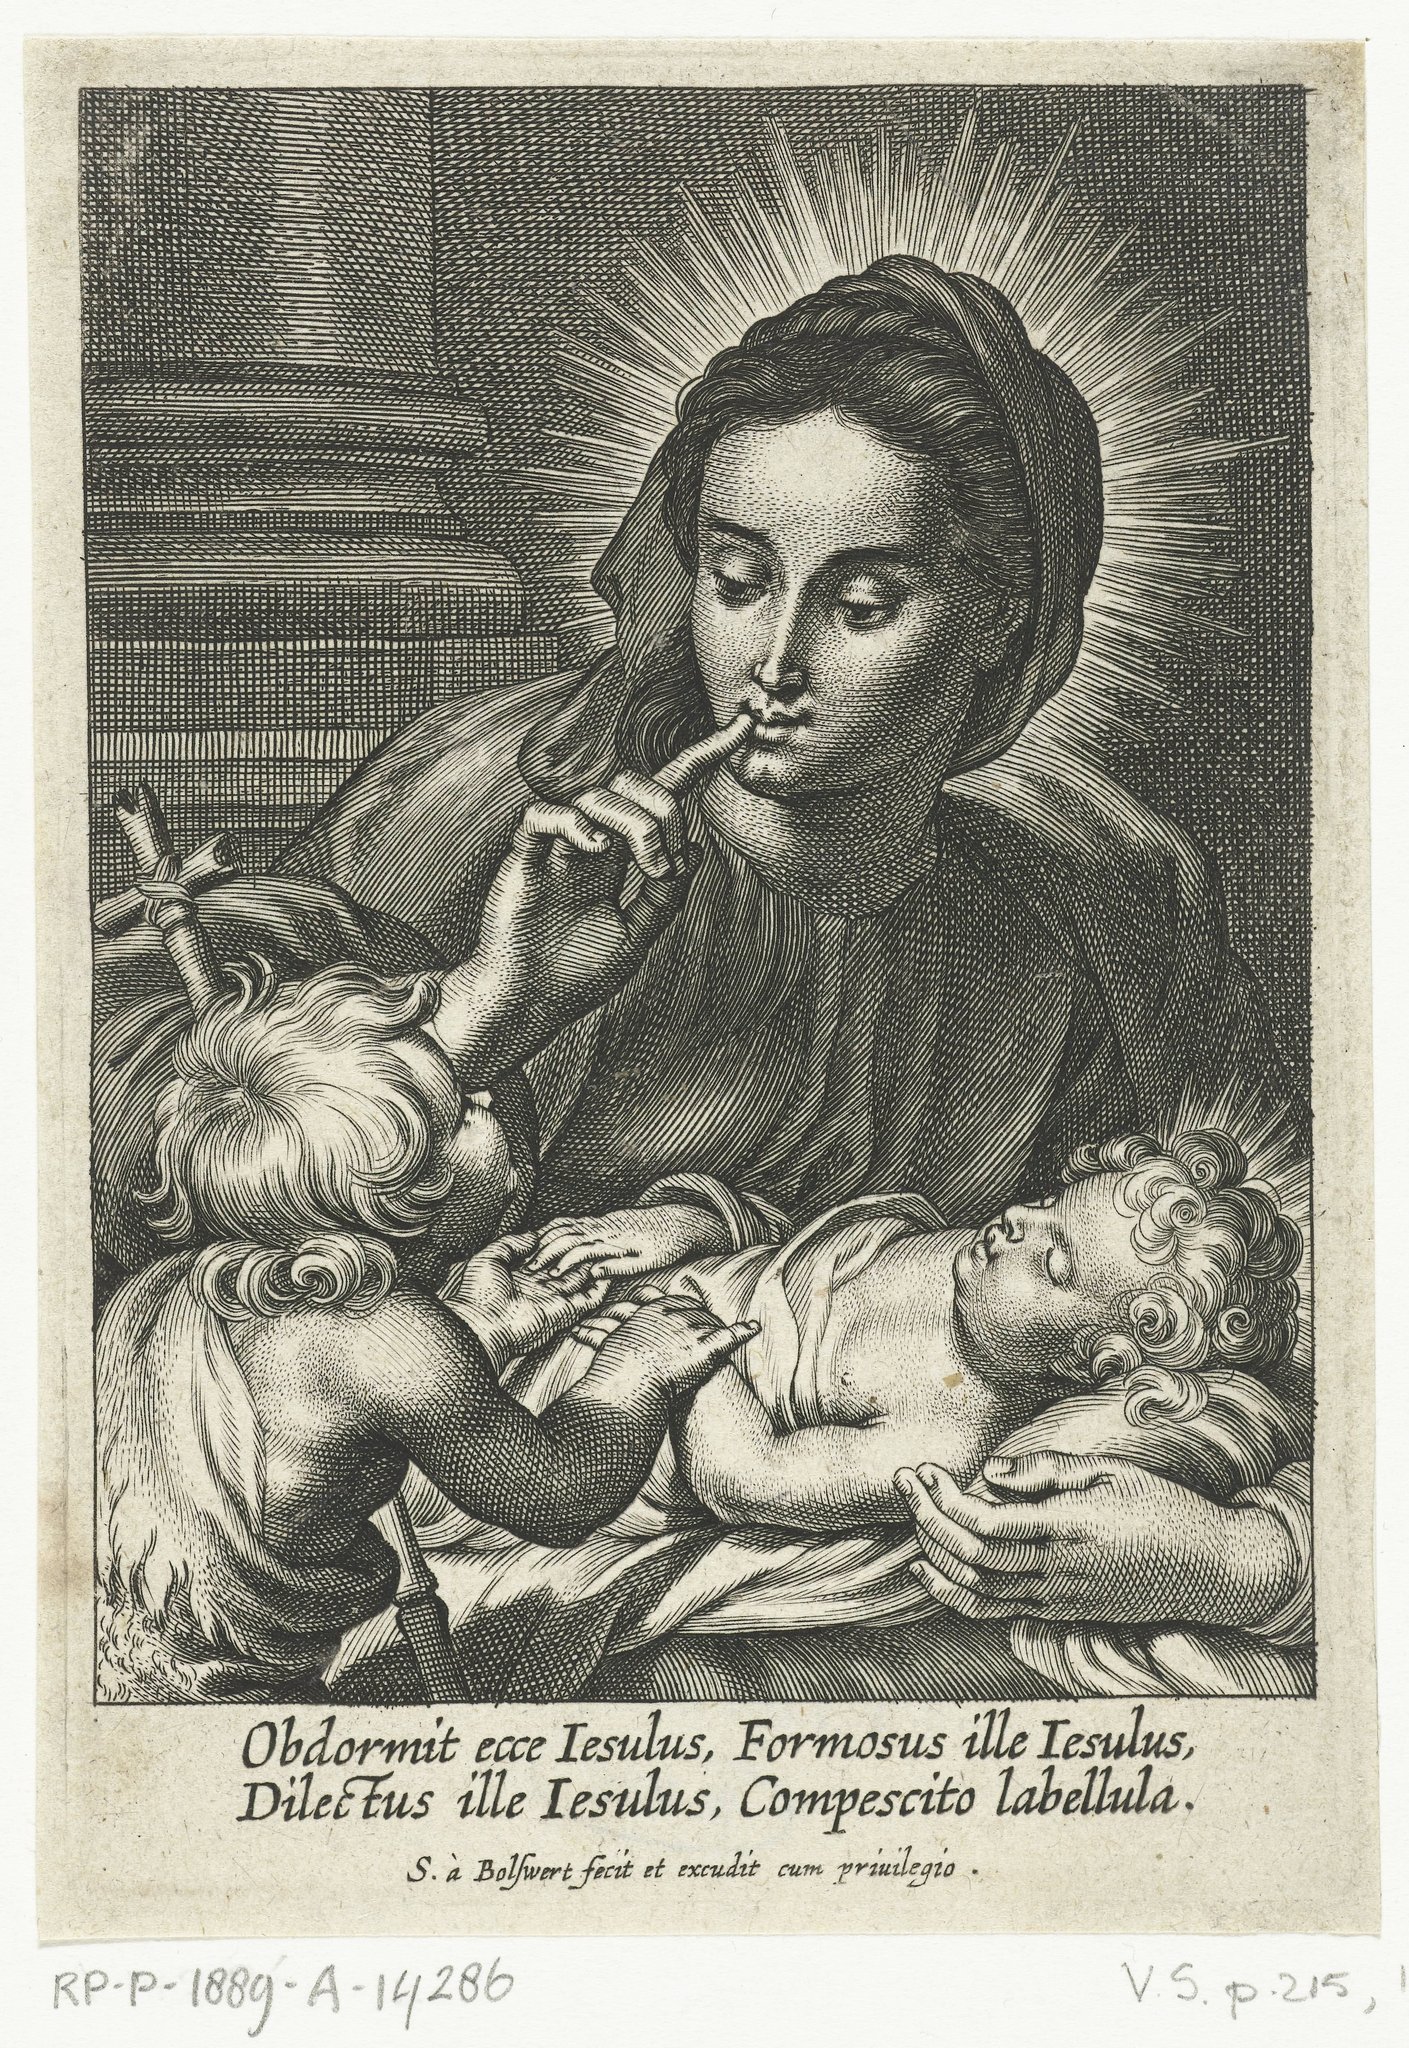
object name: print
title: Maria met slapend Christuskind en Johannes de Doper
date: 1596-1659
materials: paper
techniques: engraving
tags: mary and the christ-child with john the baptist (as child)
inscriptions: inscription: ‘Obdormit ecce Iesulus, ... Iesulus, Compescito labellula’, collector's mark: Lugt 2228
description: Prent uit serie Vélins met negentig prenten naar ontwerp van Peter Paul Rubens. In de bronnen vinden we uiteenlopende gegevens over aantal en samenstelling van de serie. Hollstein hanteert het aantal van negentig prenten. De reeks Vélins in de collectie van het RMA bevat verschillende staten afkomstig uit meerdere uitgaven welke moeilijk te duiden zijn. Sommige dragen het originele adres van Schelte Adamsz. Bolswert als graveur en uitgever, op andere exemplaren is deze naam verwijderd (duidelijk zichtbaar!) en vervangen door de naam Cornelis Galle (II). De prenten met de naam van uitgever Galle zijn vaak opgewerkt. We treffen nog een andere naam van een uitgever bij enkele prent aan: Martien van den Enden. Herkomst uit meerdere uitgaven spreekt ook uit afwijkende opschriften in Nederlands en Latijn en variaties op dezelfde thema's welke misschien nooit langs elkaar in dezelfde serie gebruikt werden.